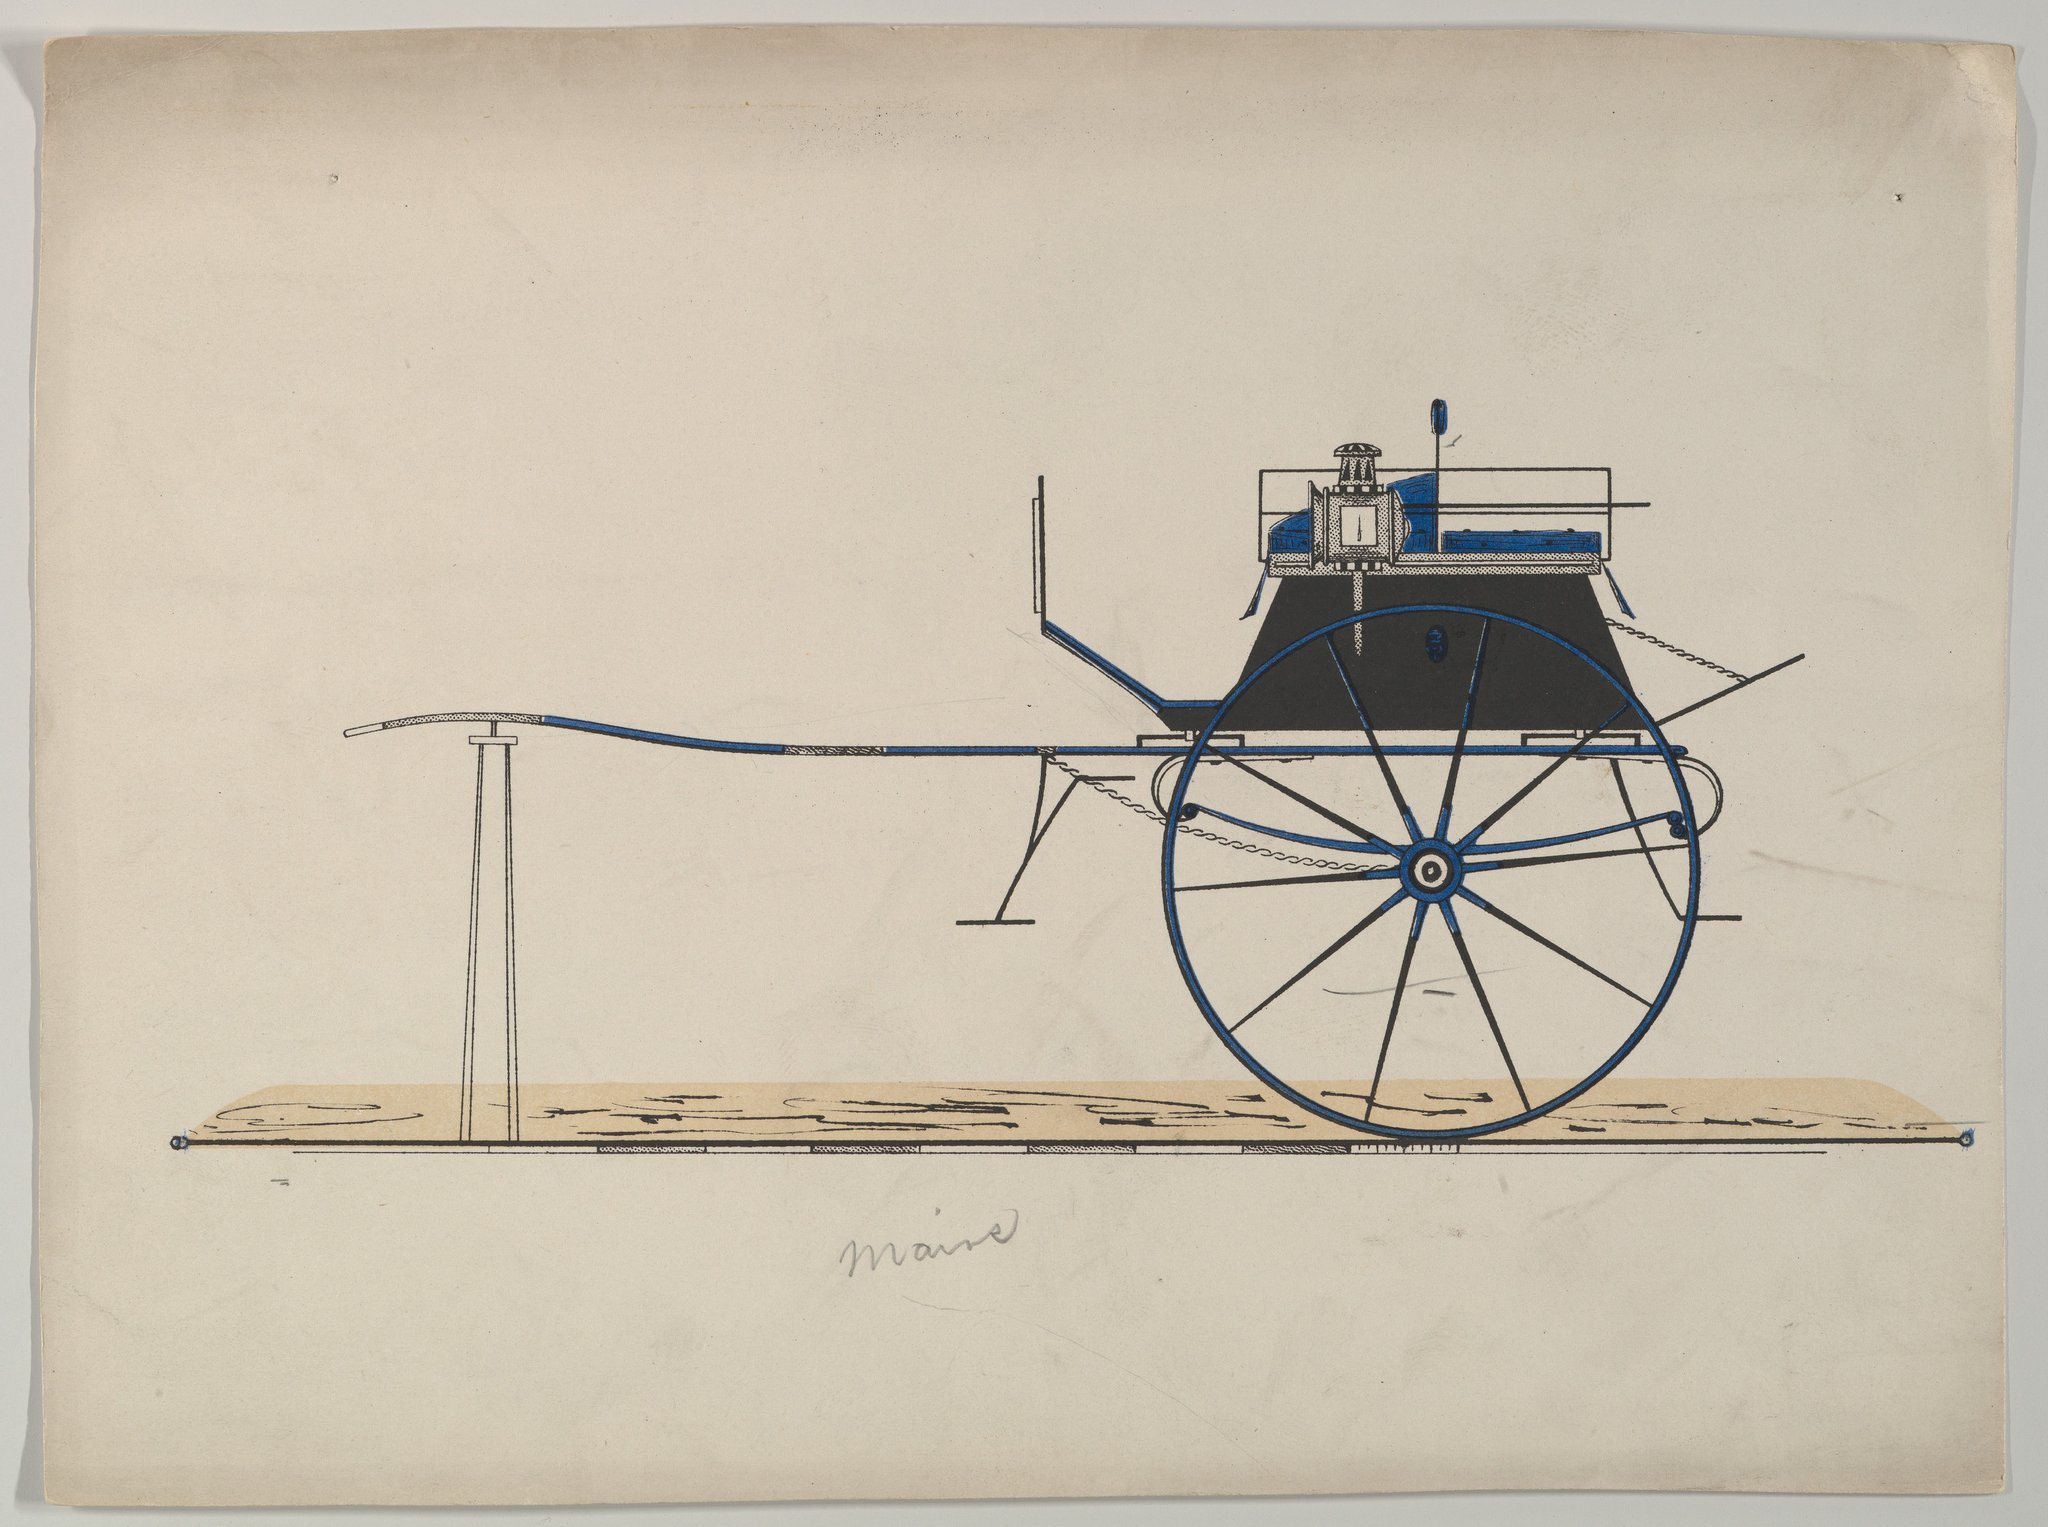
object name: drawing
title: Dog Cart (unnumbered)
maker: brewster & co.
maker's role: manufacturer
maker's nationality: american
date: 1850-1874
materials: graphite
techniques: engraving, hand coloring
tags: carriages